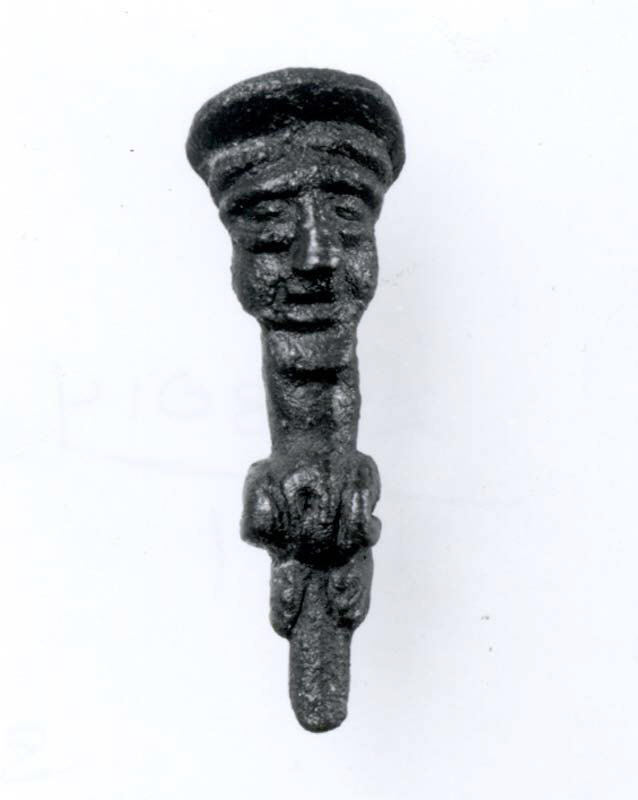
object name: pin head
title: Head of a pin: seated figure with cap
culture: iranian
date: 800-601 BCE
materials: copper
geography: iran, luristan